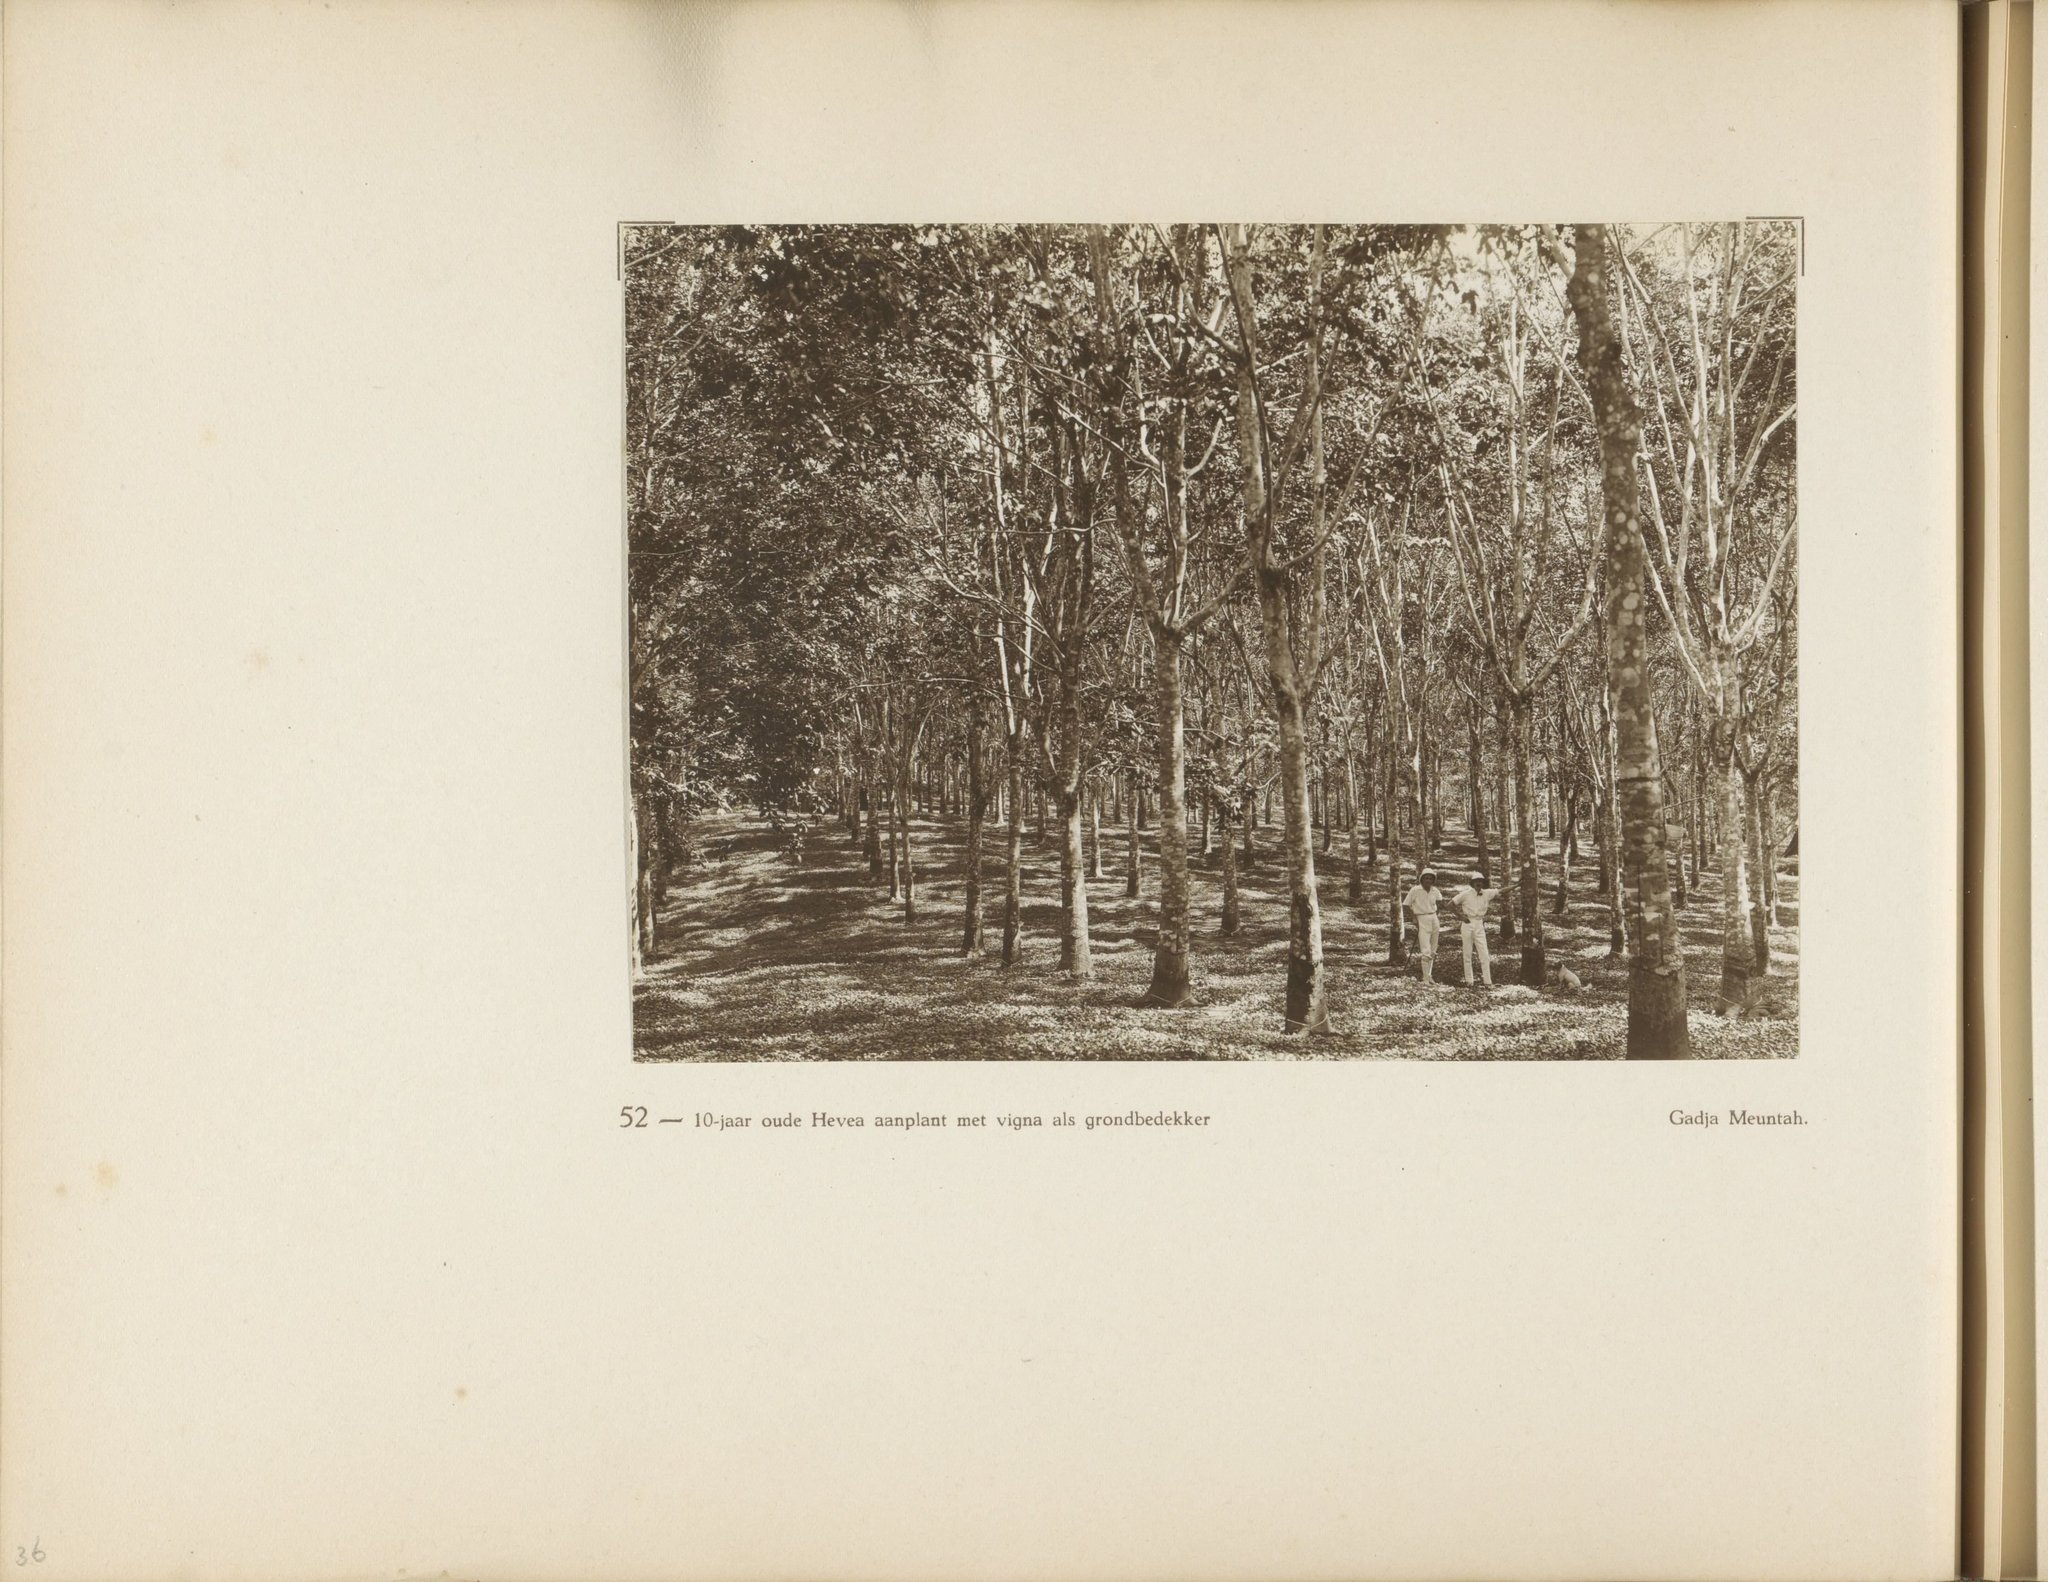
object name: photograph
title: Pagina 52 van fotoboek van de Algemeene Vereeniging van Rubberplanters ter Oostkust van Sumatra (A.V.R.O.S.)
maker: j.w. meyster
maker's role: fotograaf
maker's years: 1887-1945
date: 1924-1925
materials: paper, photographic support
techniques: printing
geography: dutch east indies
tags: plantation, (non-fruit) products of plants or trees: rubber, sumatra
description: Boekpagina met een foto van mannen poserend temidden van tien jaar oude hevea-aanplant te Gadja Meuntah. Onderdeel van een fotoboek van de Algemeene Vereeniging van Rubberplanters ter Oostkust van Sumatra (A.V.R.O.S.).